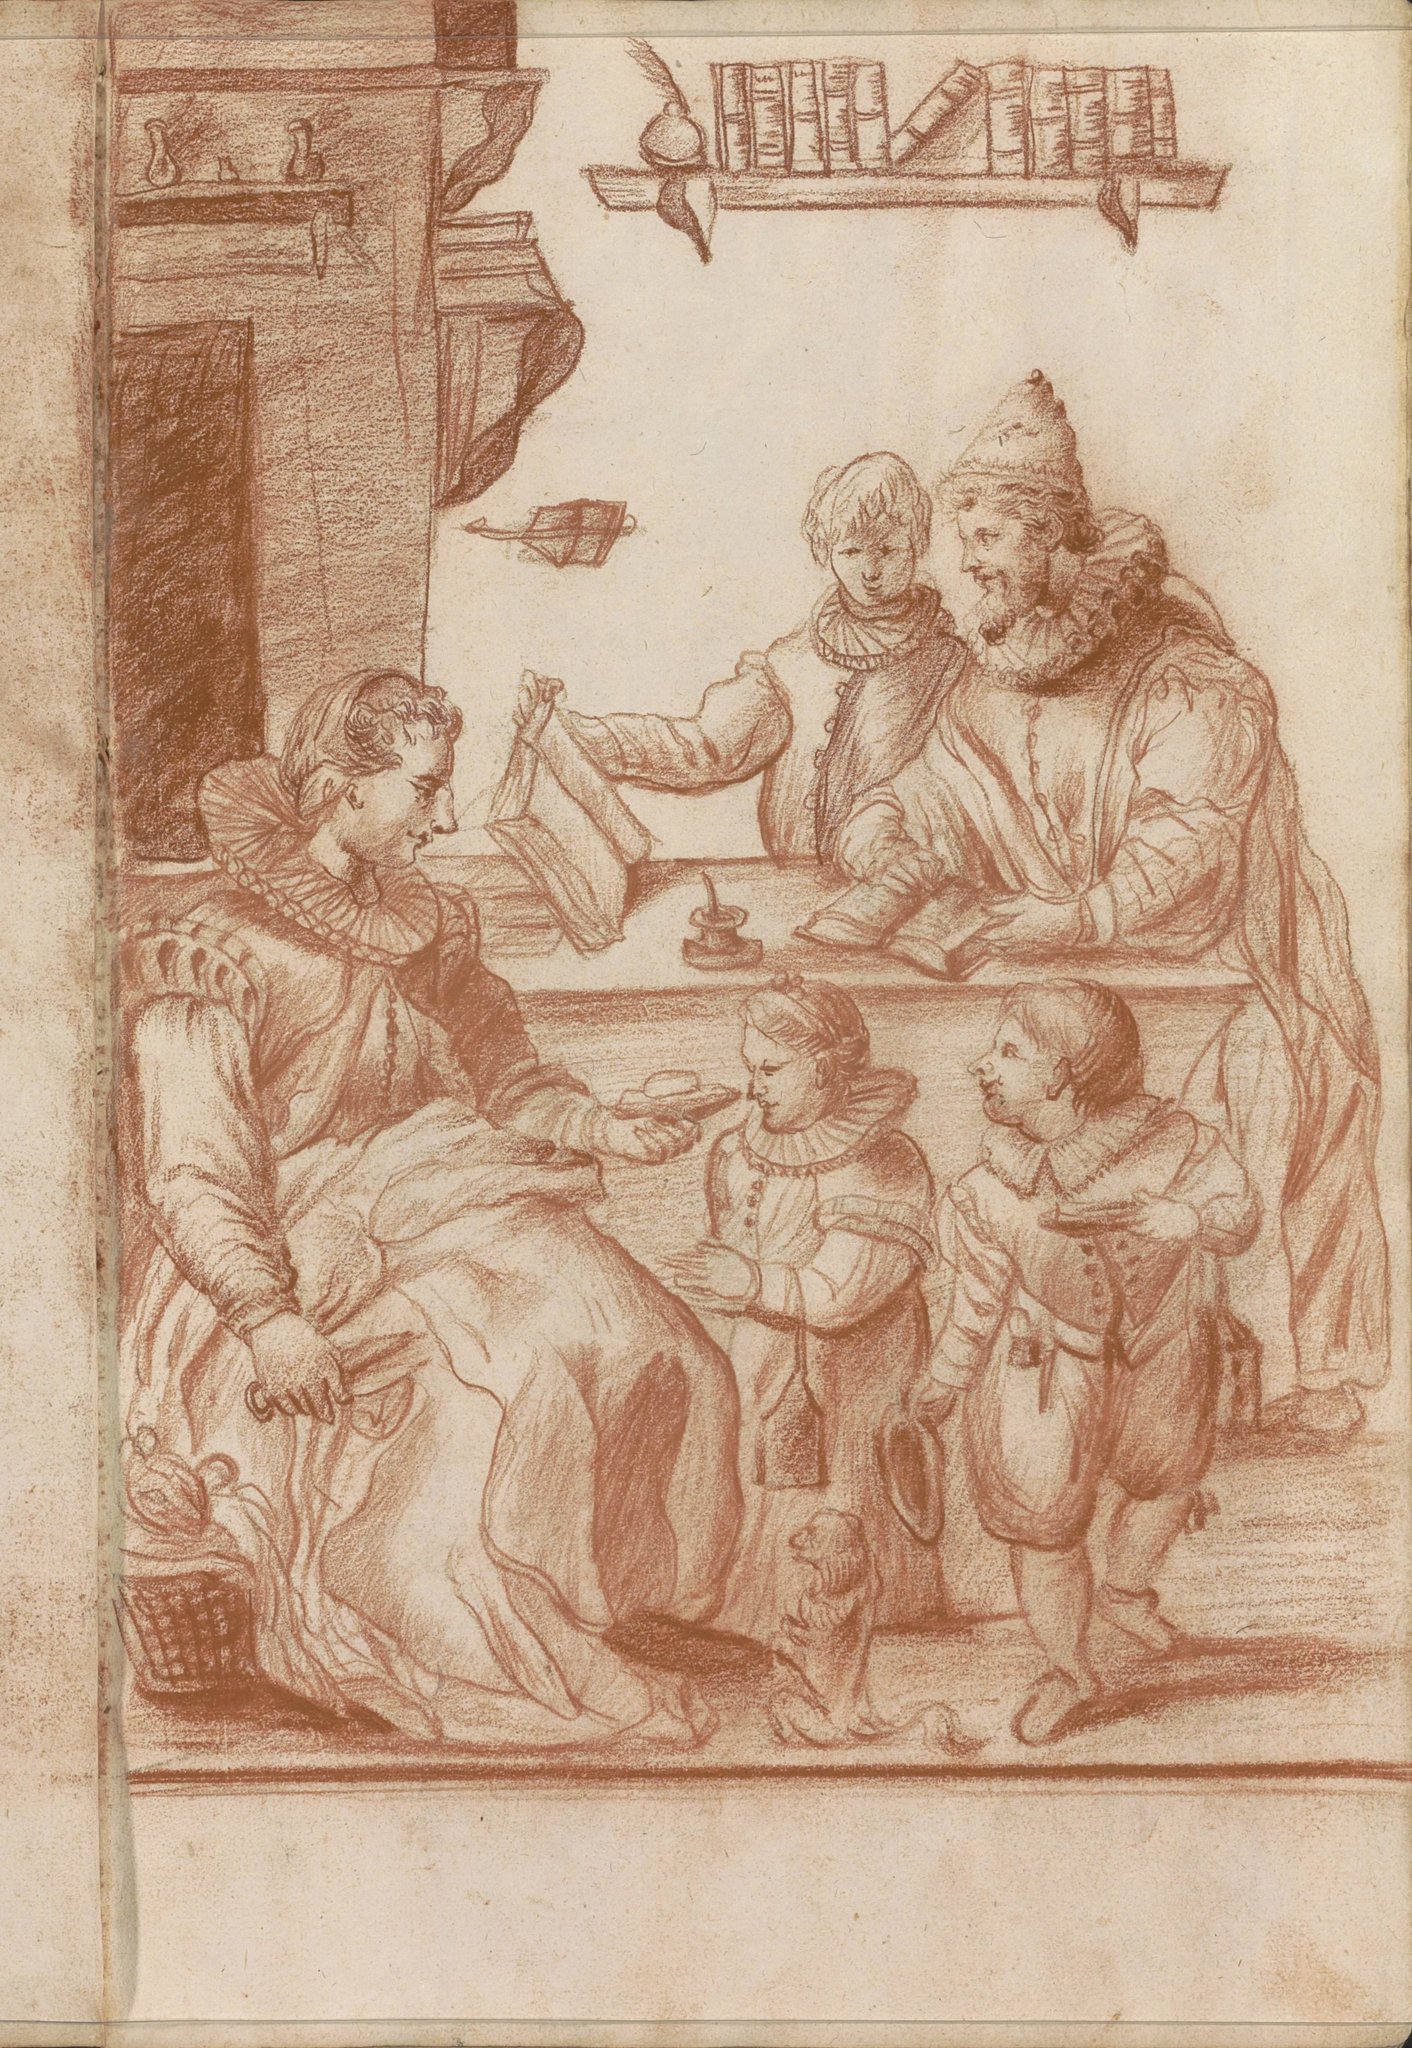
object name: sketchbook leaf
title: Ochtend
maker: hendrick van beaumont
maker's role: draughtsman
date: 1696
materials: chalk, paper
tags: morning ~ other concepts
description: Interieur met een moeder die één van haar twee kinderen een boterham geeft. Achter hen staat de vader met de oudste zoon aan een tafel met boeken en een inktpot. Blad 59 recto uit een schetsboek met 91 bladen.